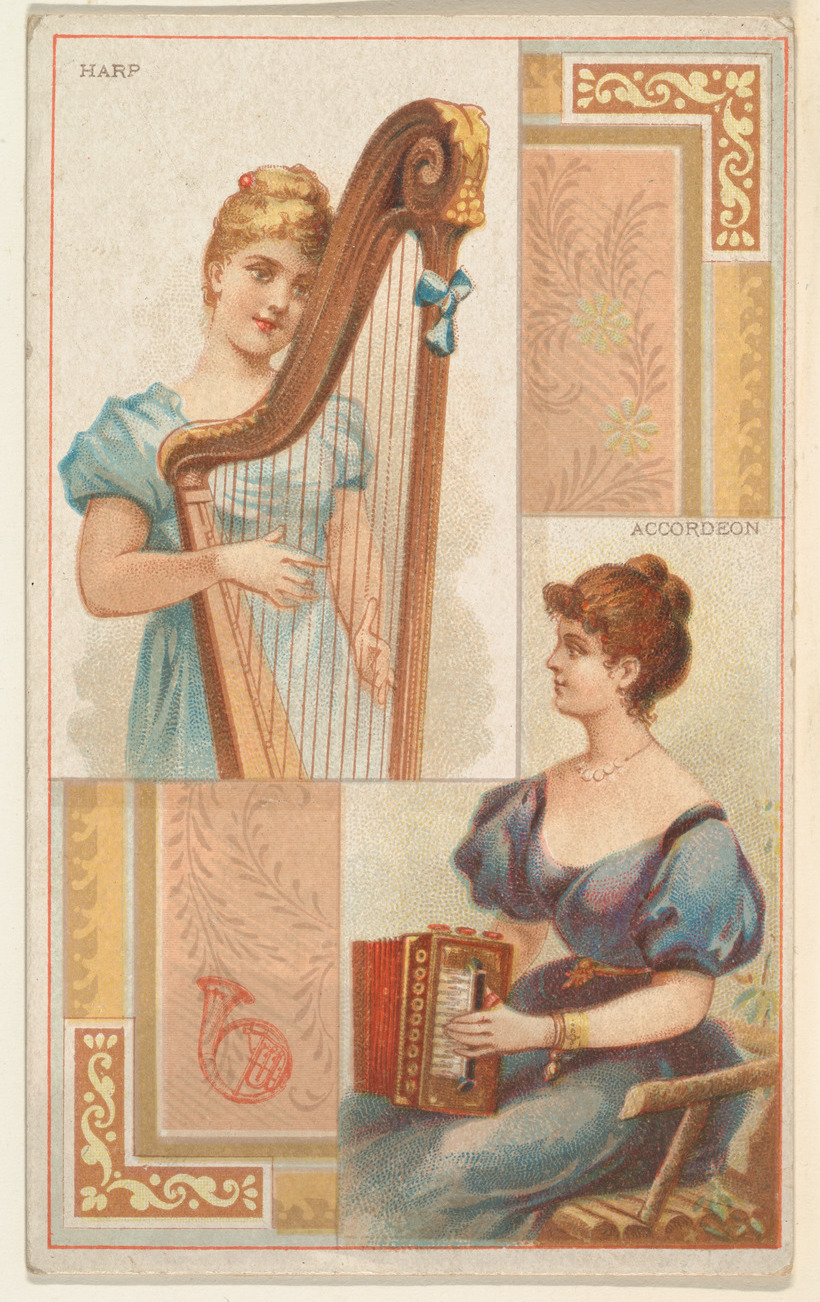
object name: print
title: Harp and Accordion, from the Musical Instruments series (N121) issued by Duke Sons & Co. to promote Honest Long Cut Tobacco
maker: w. duke, sons & co.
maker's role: publisher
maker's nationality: american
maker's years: 1870-1920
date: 1888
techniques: color lithograph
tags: profiles,women,accordions,harps